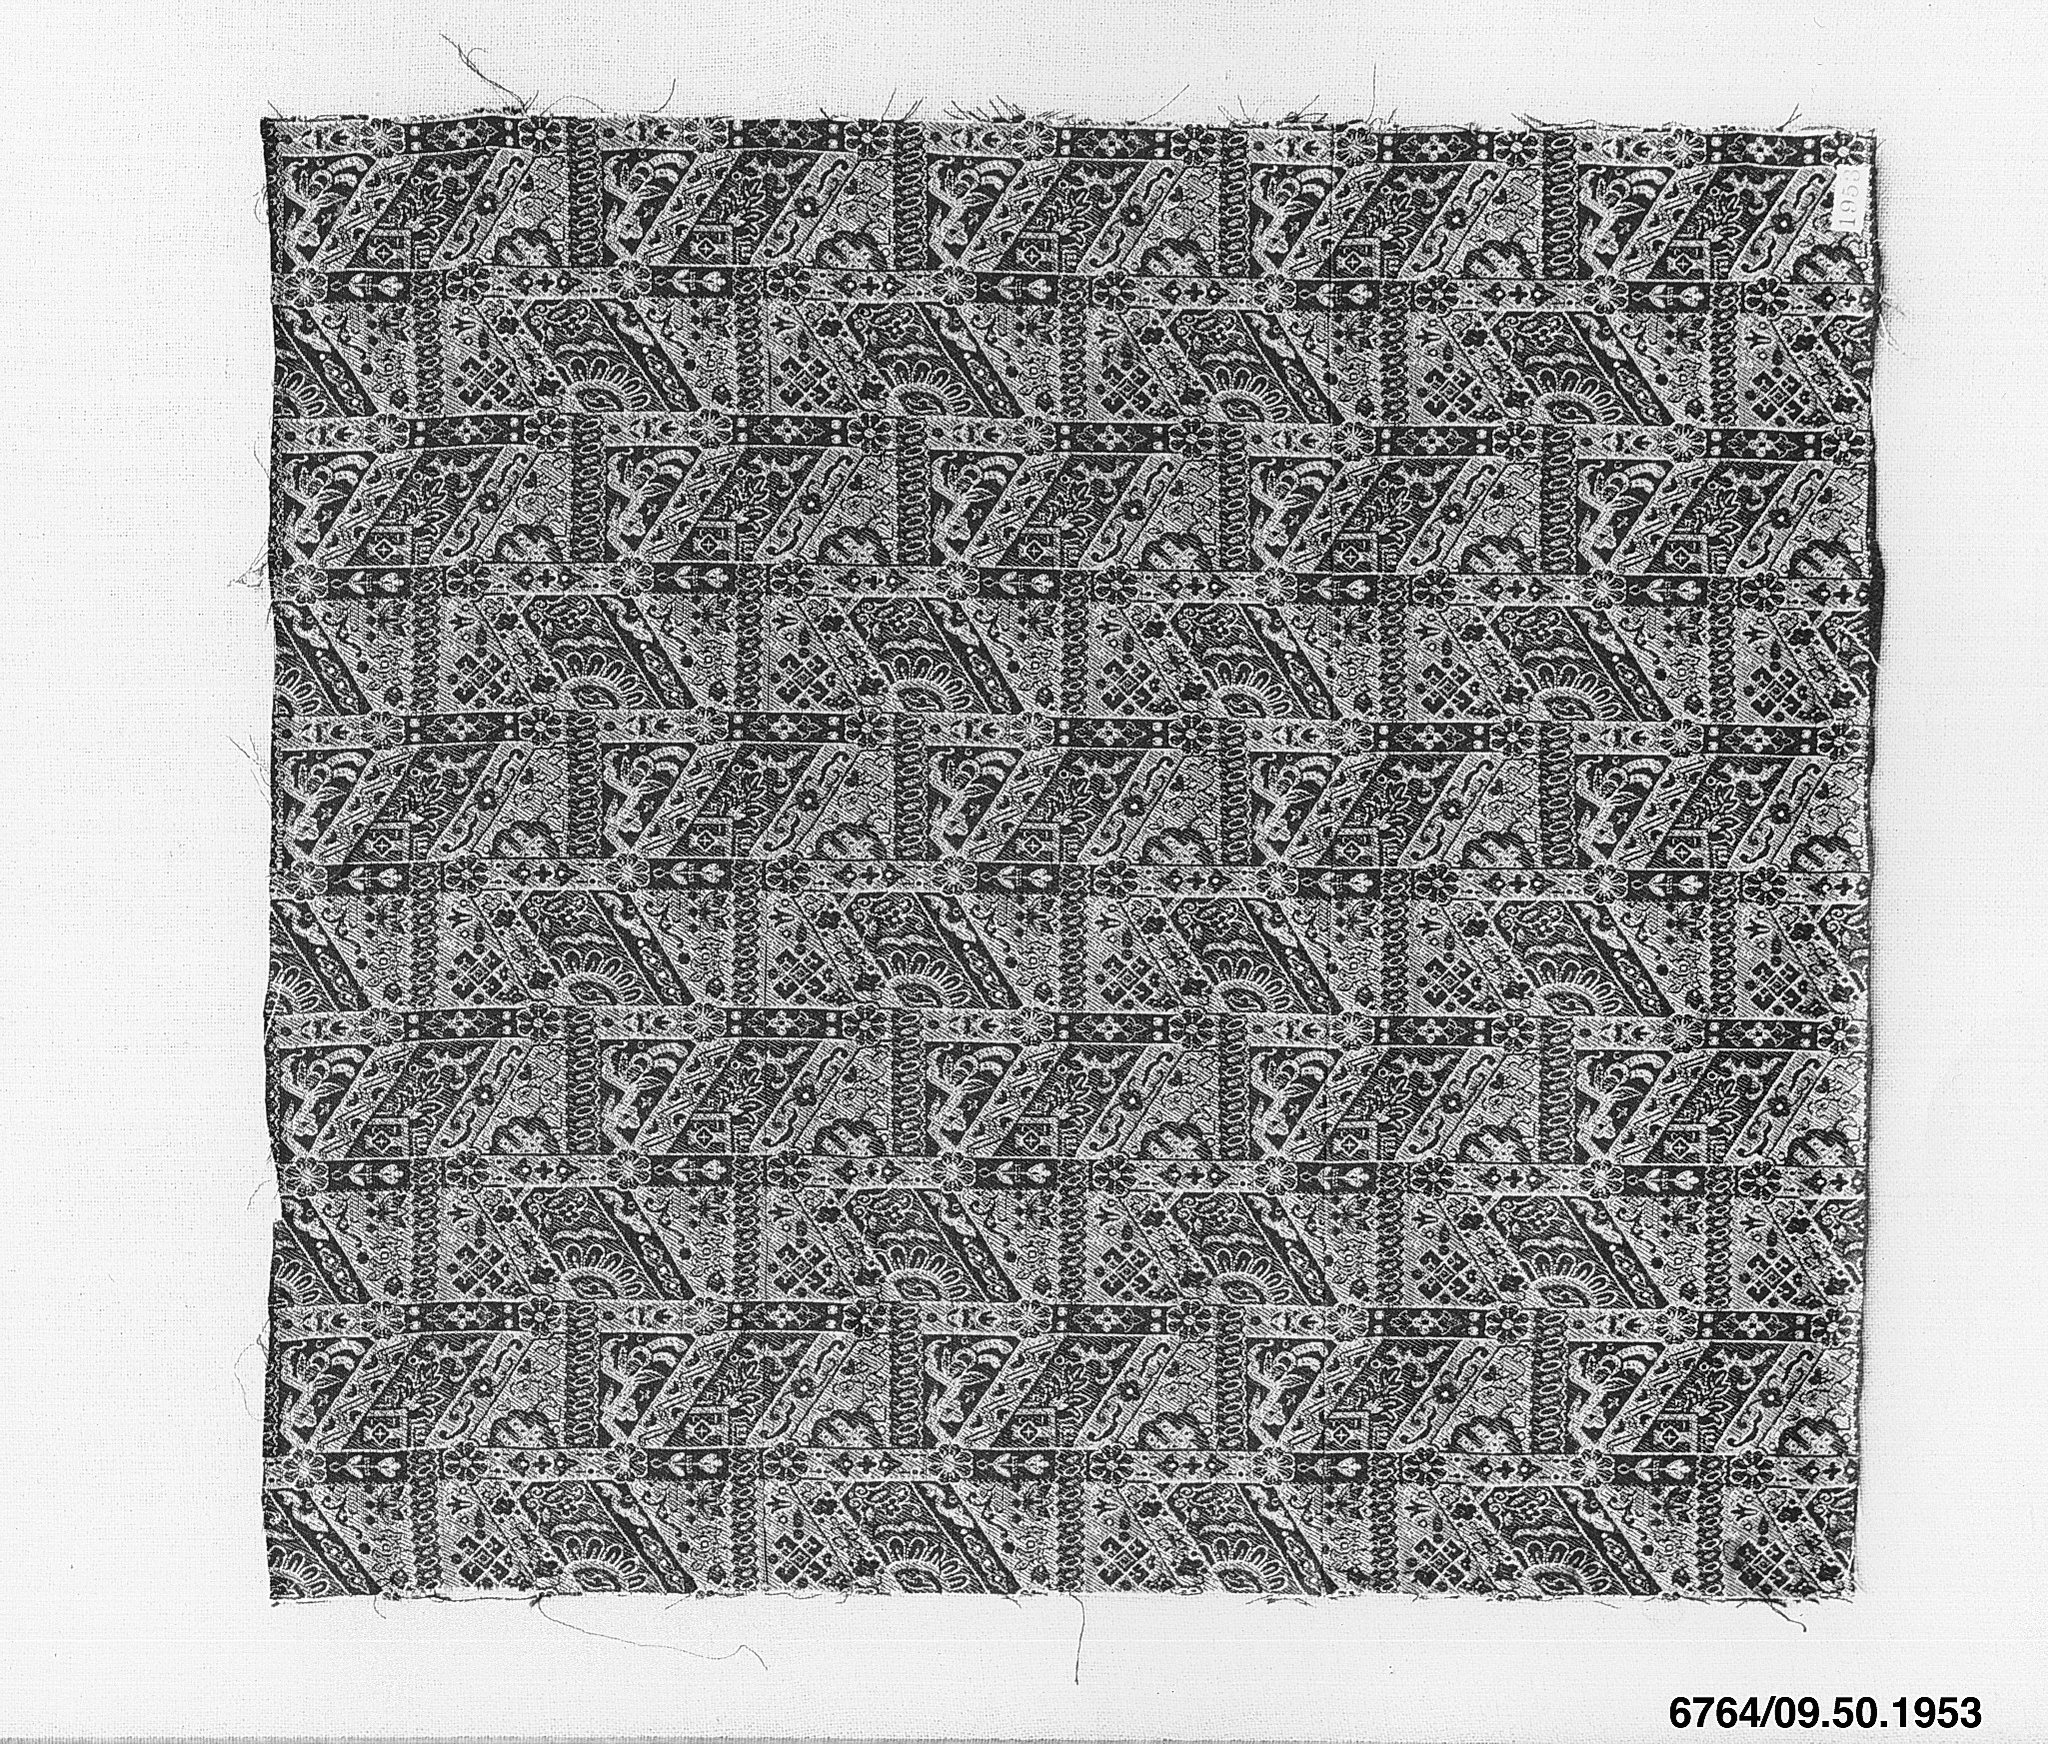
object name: piece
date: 1834-1866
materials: silk, wool